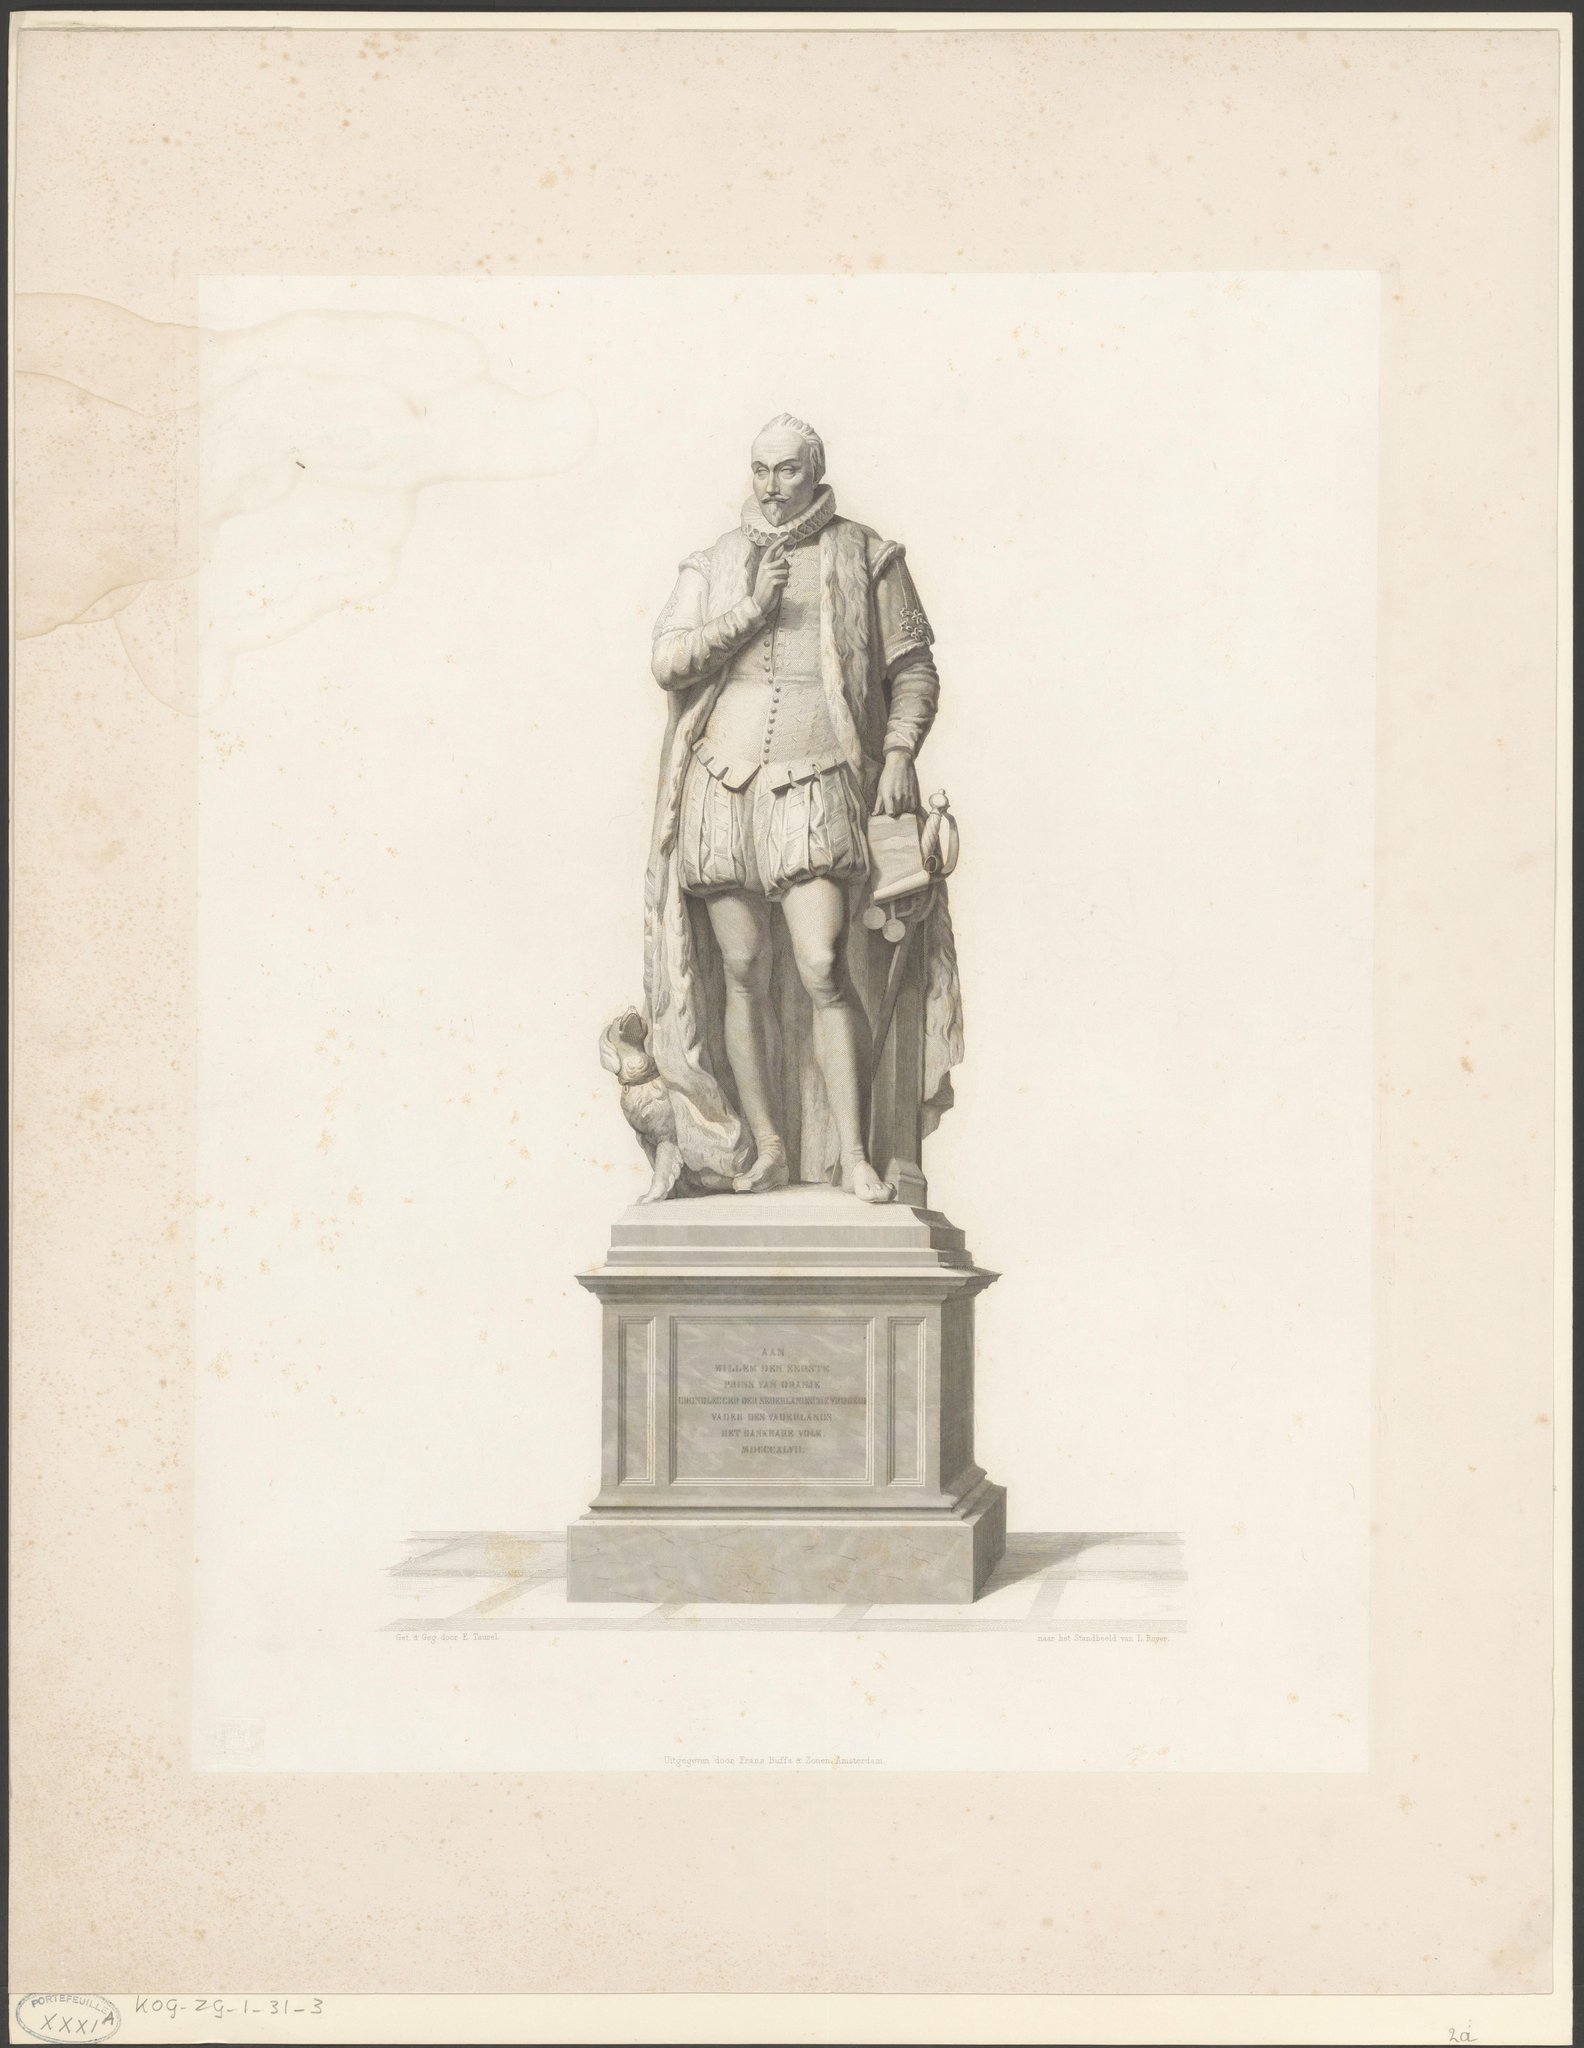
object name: print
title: Standbeeld van Prins Willem I op het Plein te Den Haag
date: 1847-1892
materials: paper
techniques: engraving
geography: amsterdam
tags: delft, william i (prince of orange), historical persons, monument, statue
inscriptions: collector's mark: Lugt 1641, check stamp, stamp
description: Standbeeld van Prins Willem I door Louis Royer op het Plein te Den Haag. Onderwerpsrubrieken binnen de Atlas Zeden en Gewoonten: Portretten, Portretten van Vorsten uit het huis van Oranje, Regeerende Vorsten, Stadhouders van Holland, Zeeland en West-Friesland.